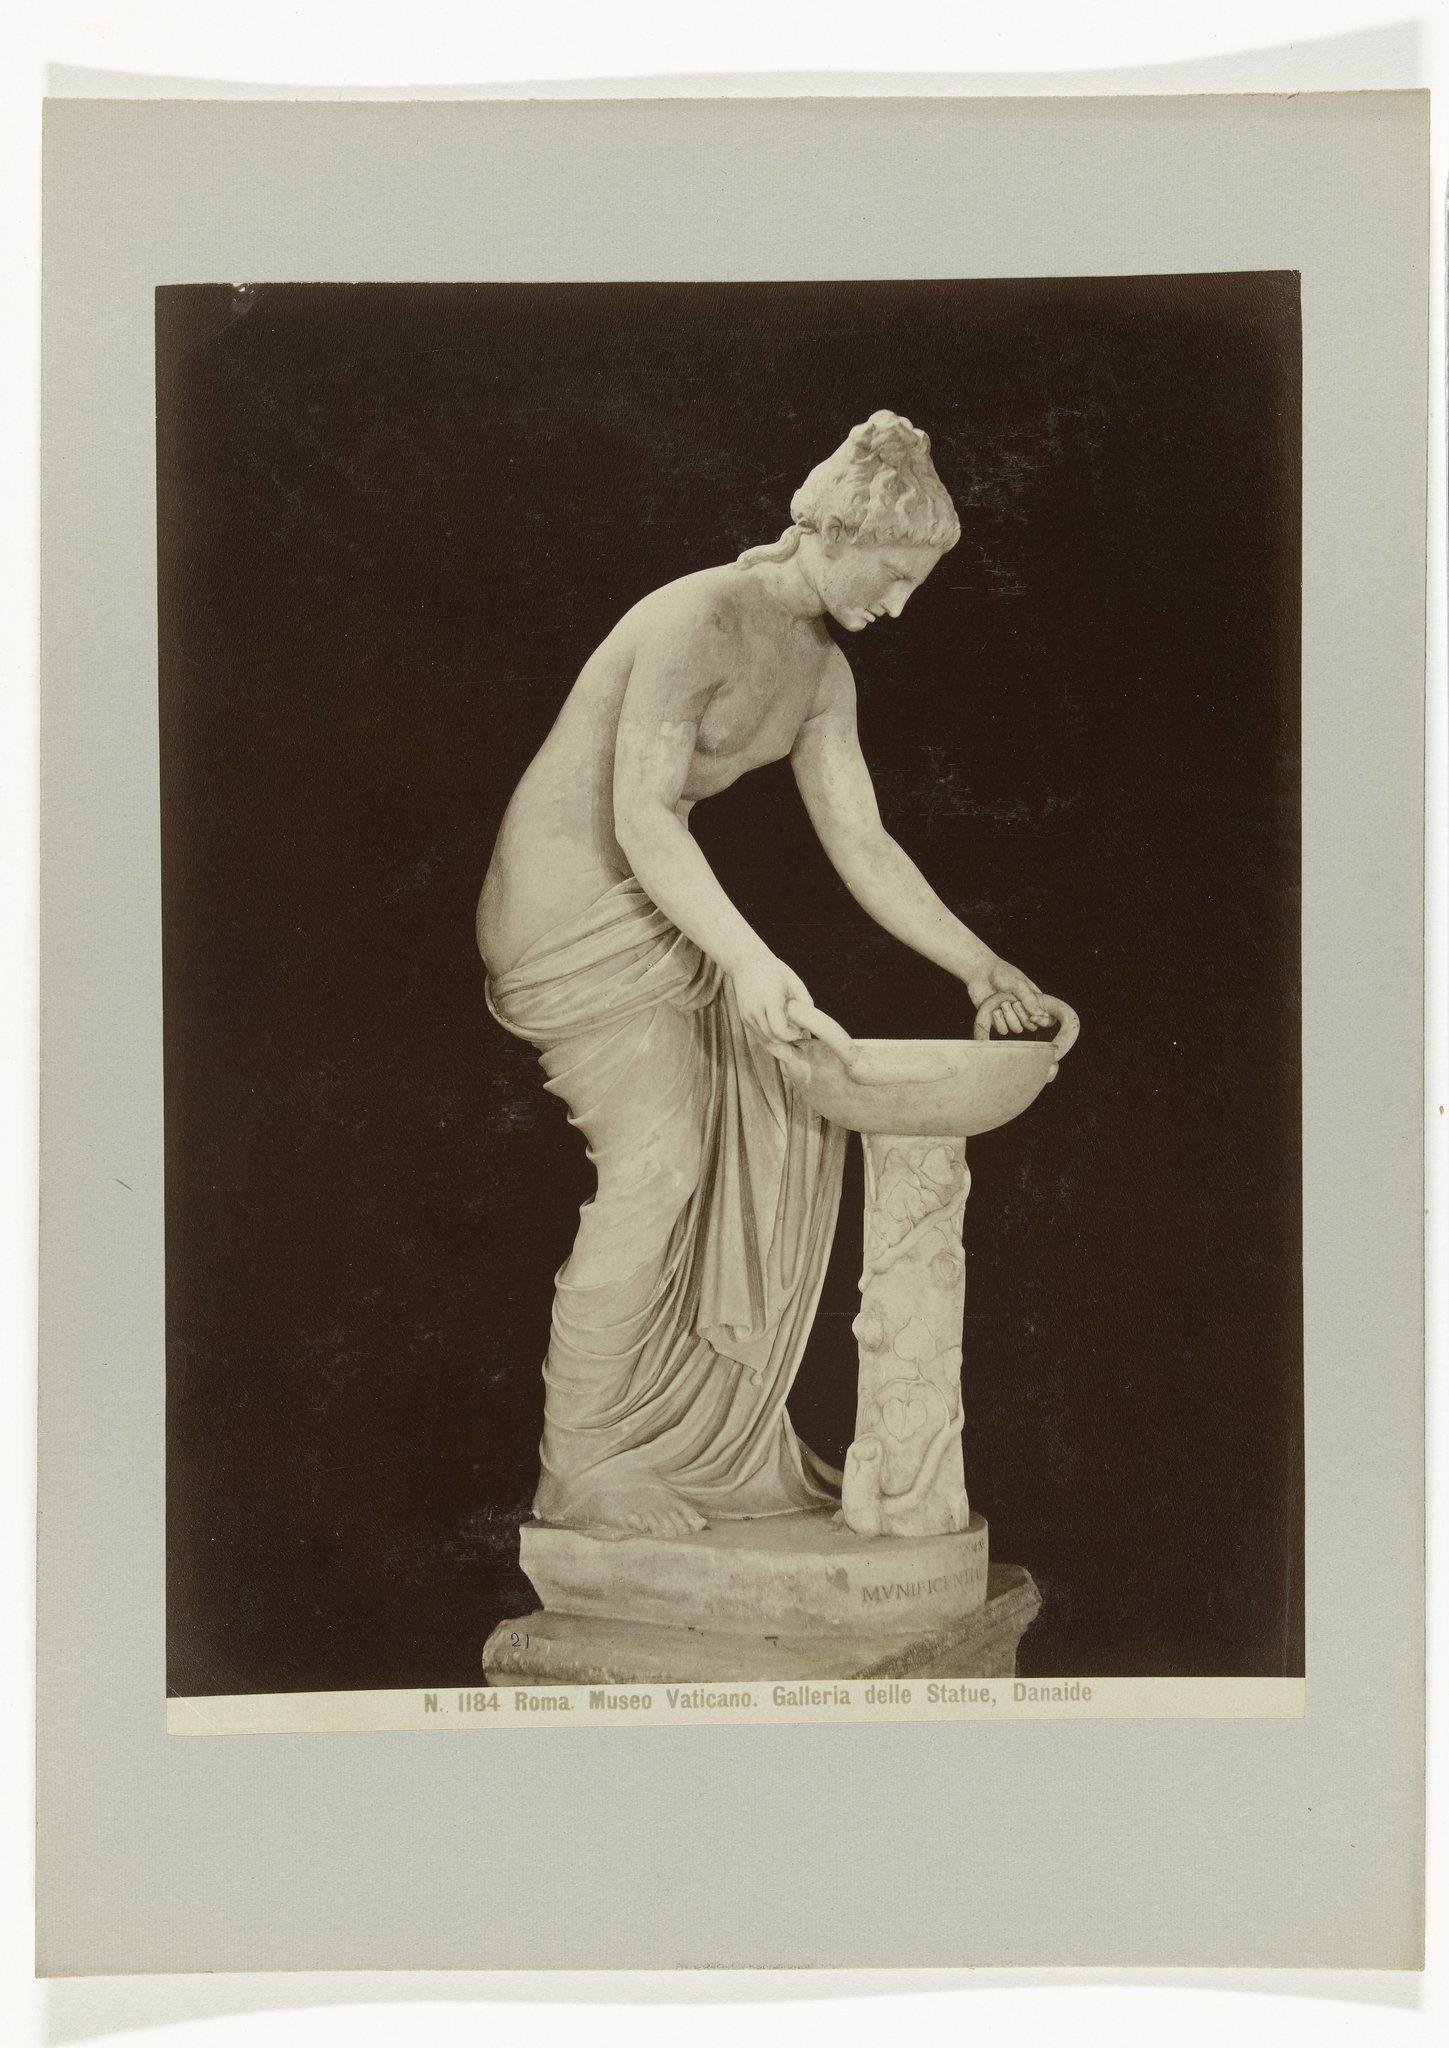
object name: photograph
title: Sculptuur van Danaïde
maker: Anonymous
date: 1880-1904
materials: cardboard, paper, photographic support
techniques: albumen print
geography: rome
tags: vaticaanse musea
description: Sculptuur van Danaïde. Linksonder op de foto is het nummer 21 geschreven met pen in zwarte inkt.